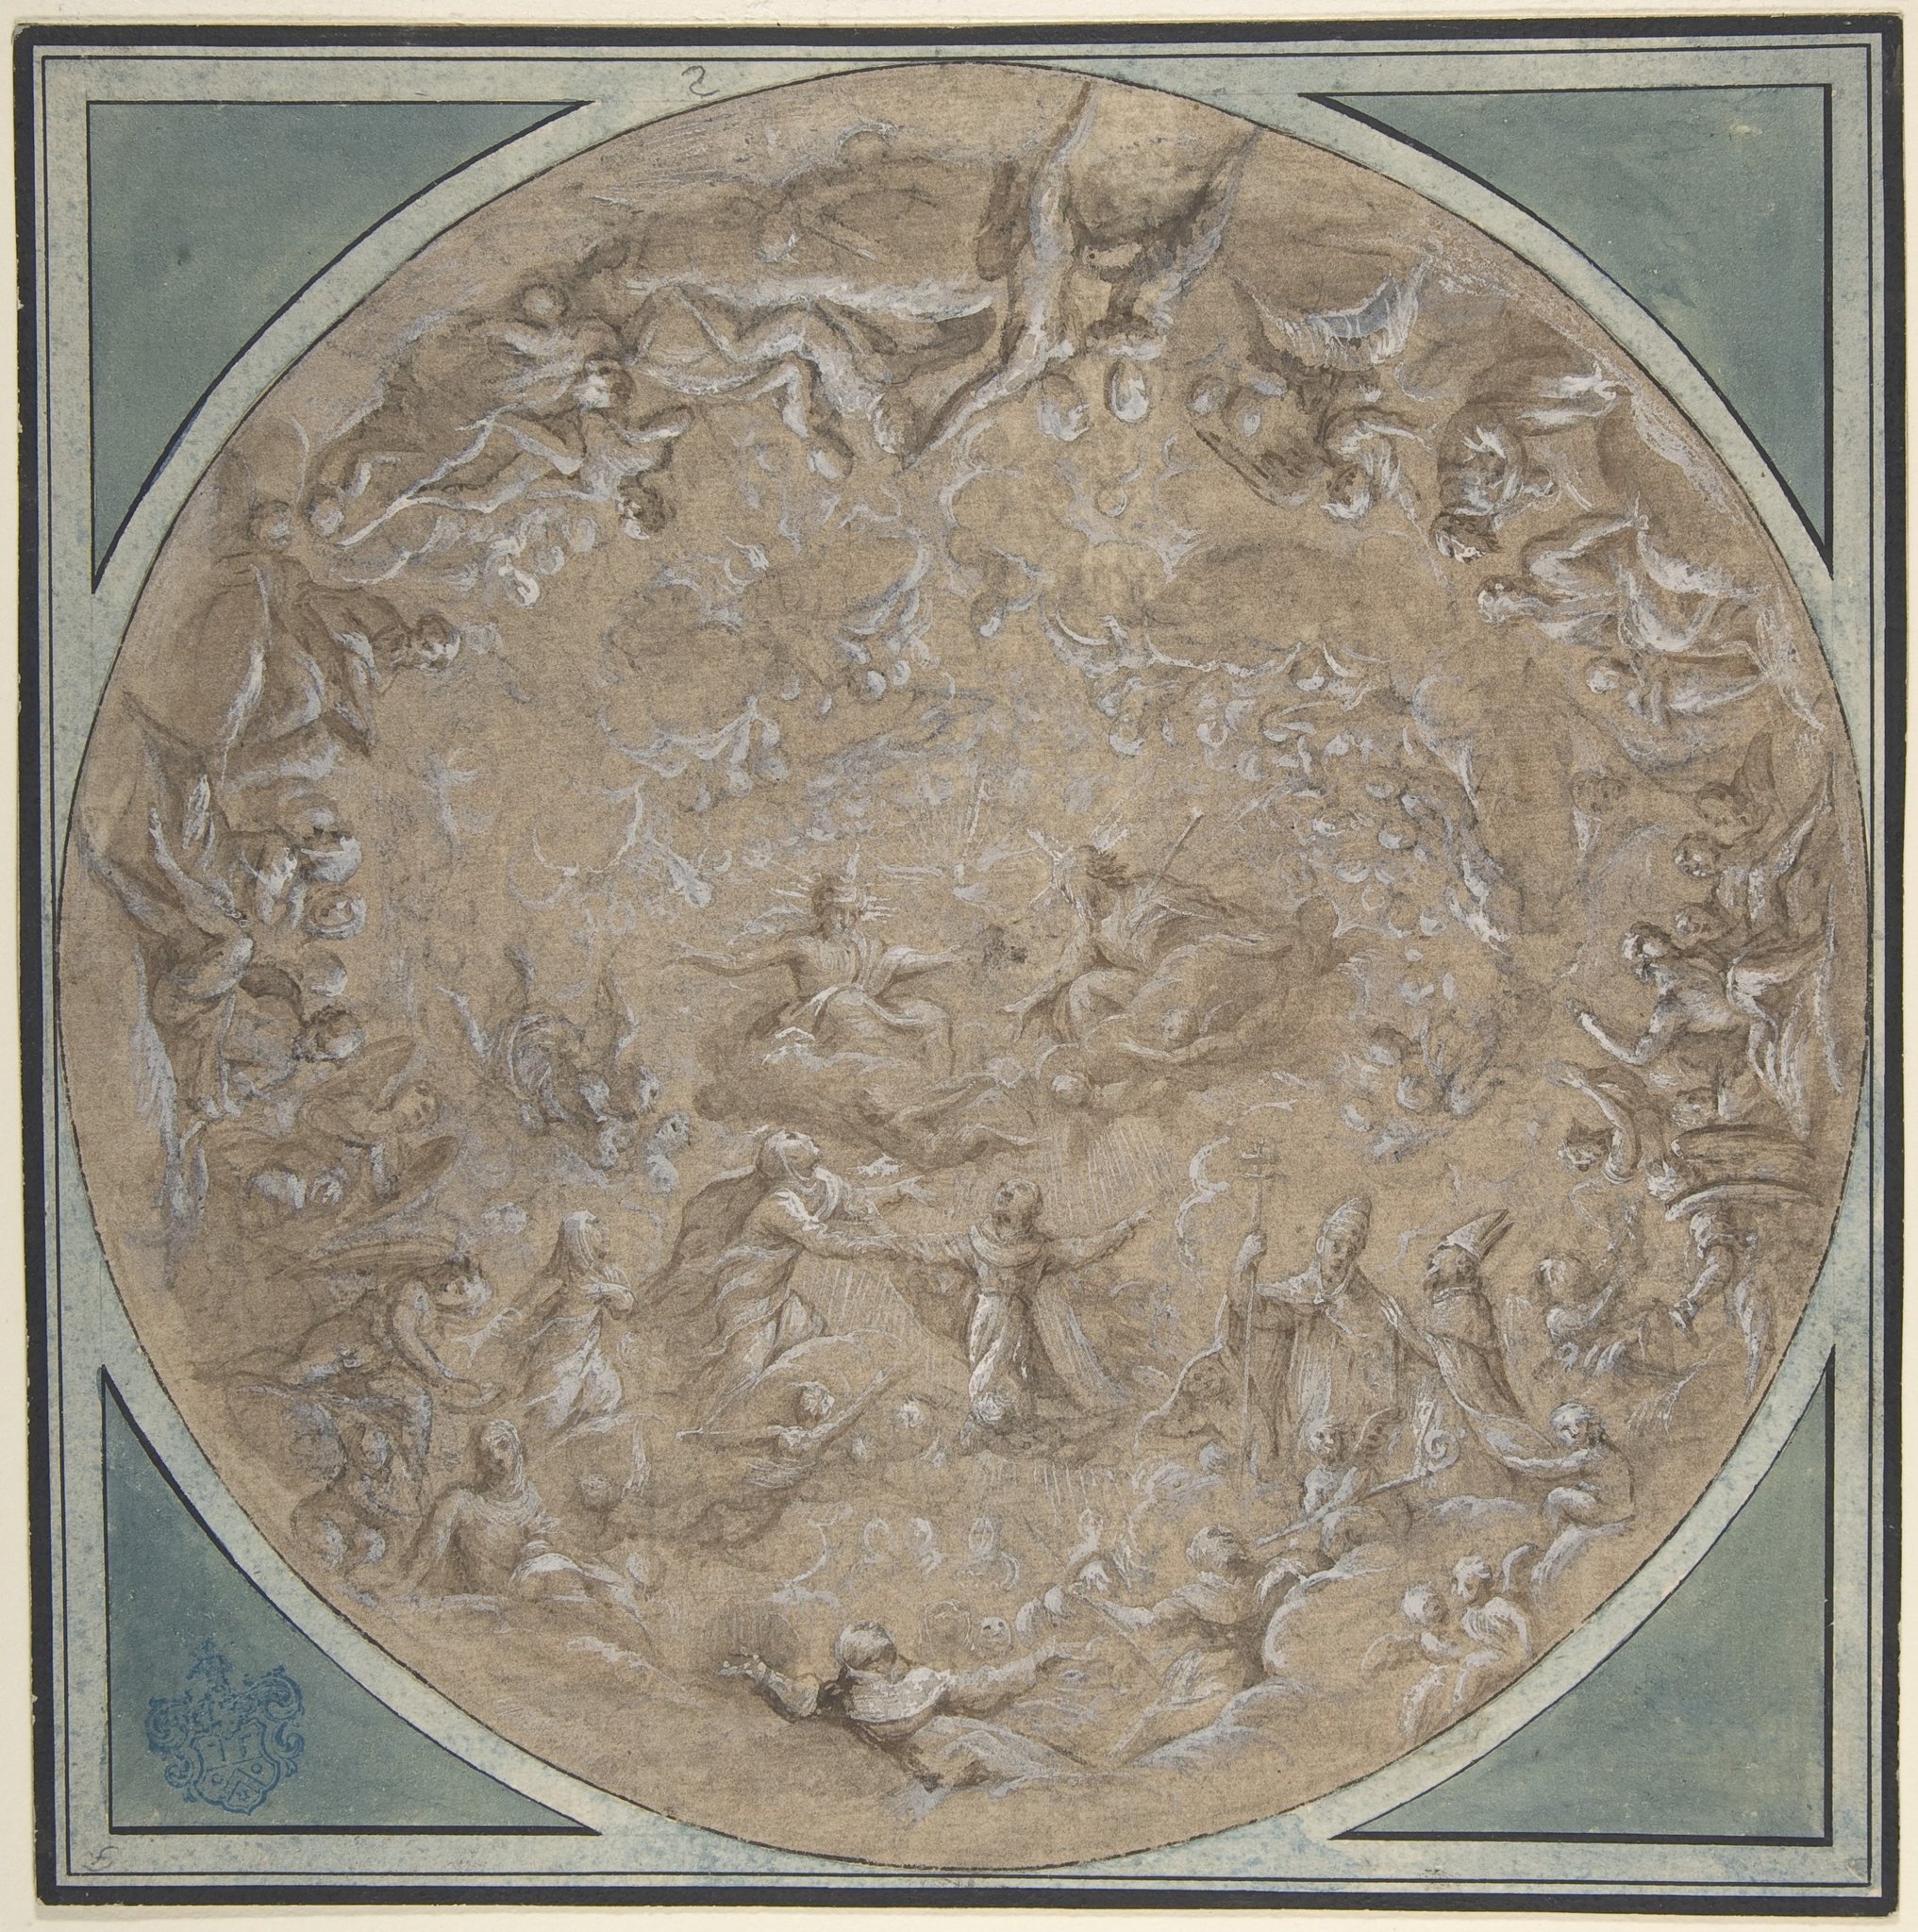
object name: drawing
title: Monastic Saint Presented to the Holy Trinity by the Virgin, Study for a Circular Ceiling Decoration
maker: lazzaro baldi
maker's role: artist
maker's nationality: italian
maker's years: 1622-1703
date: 1622-1703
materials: chalk, paper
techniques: brush, highlighting, wash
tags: angels,virgin mary,saints